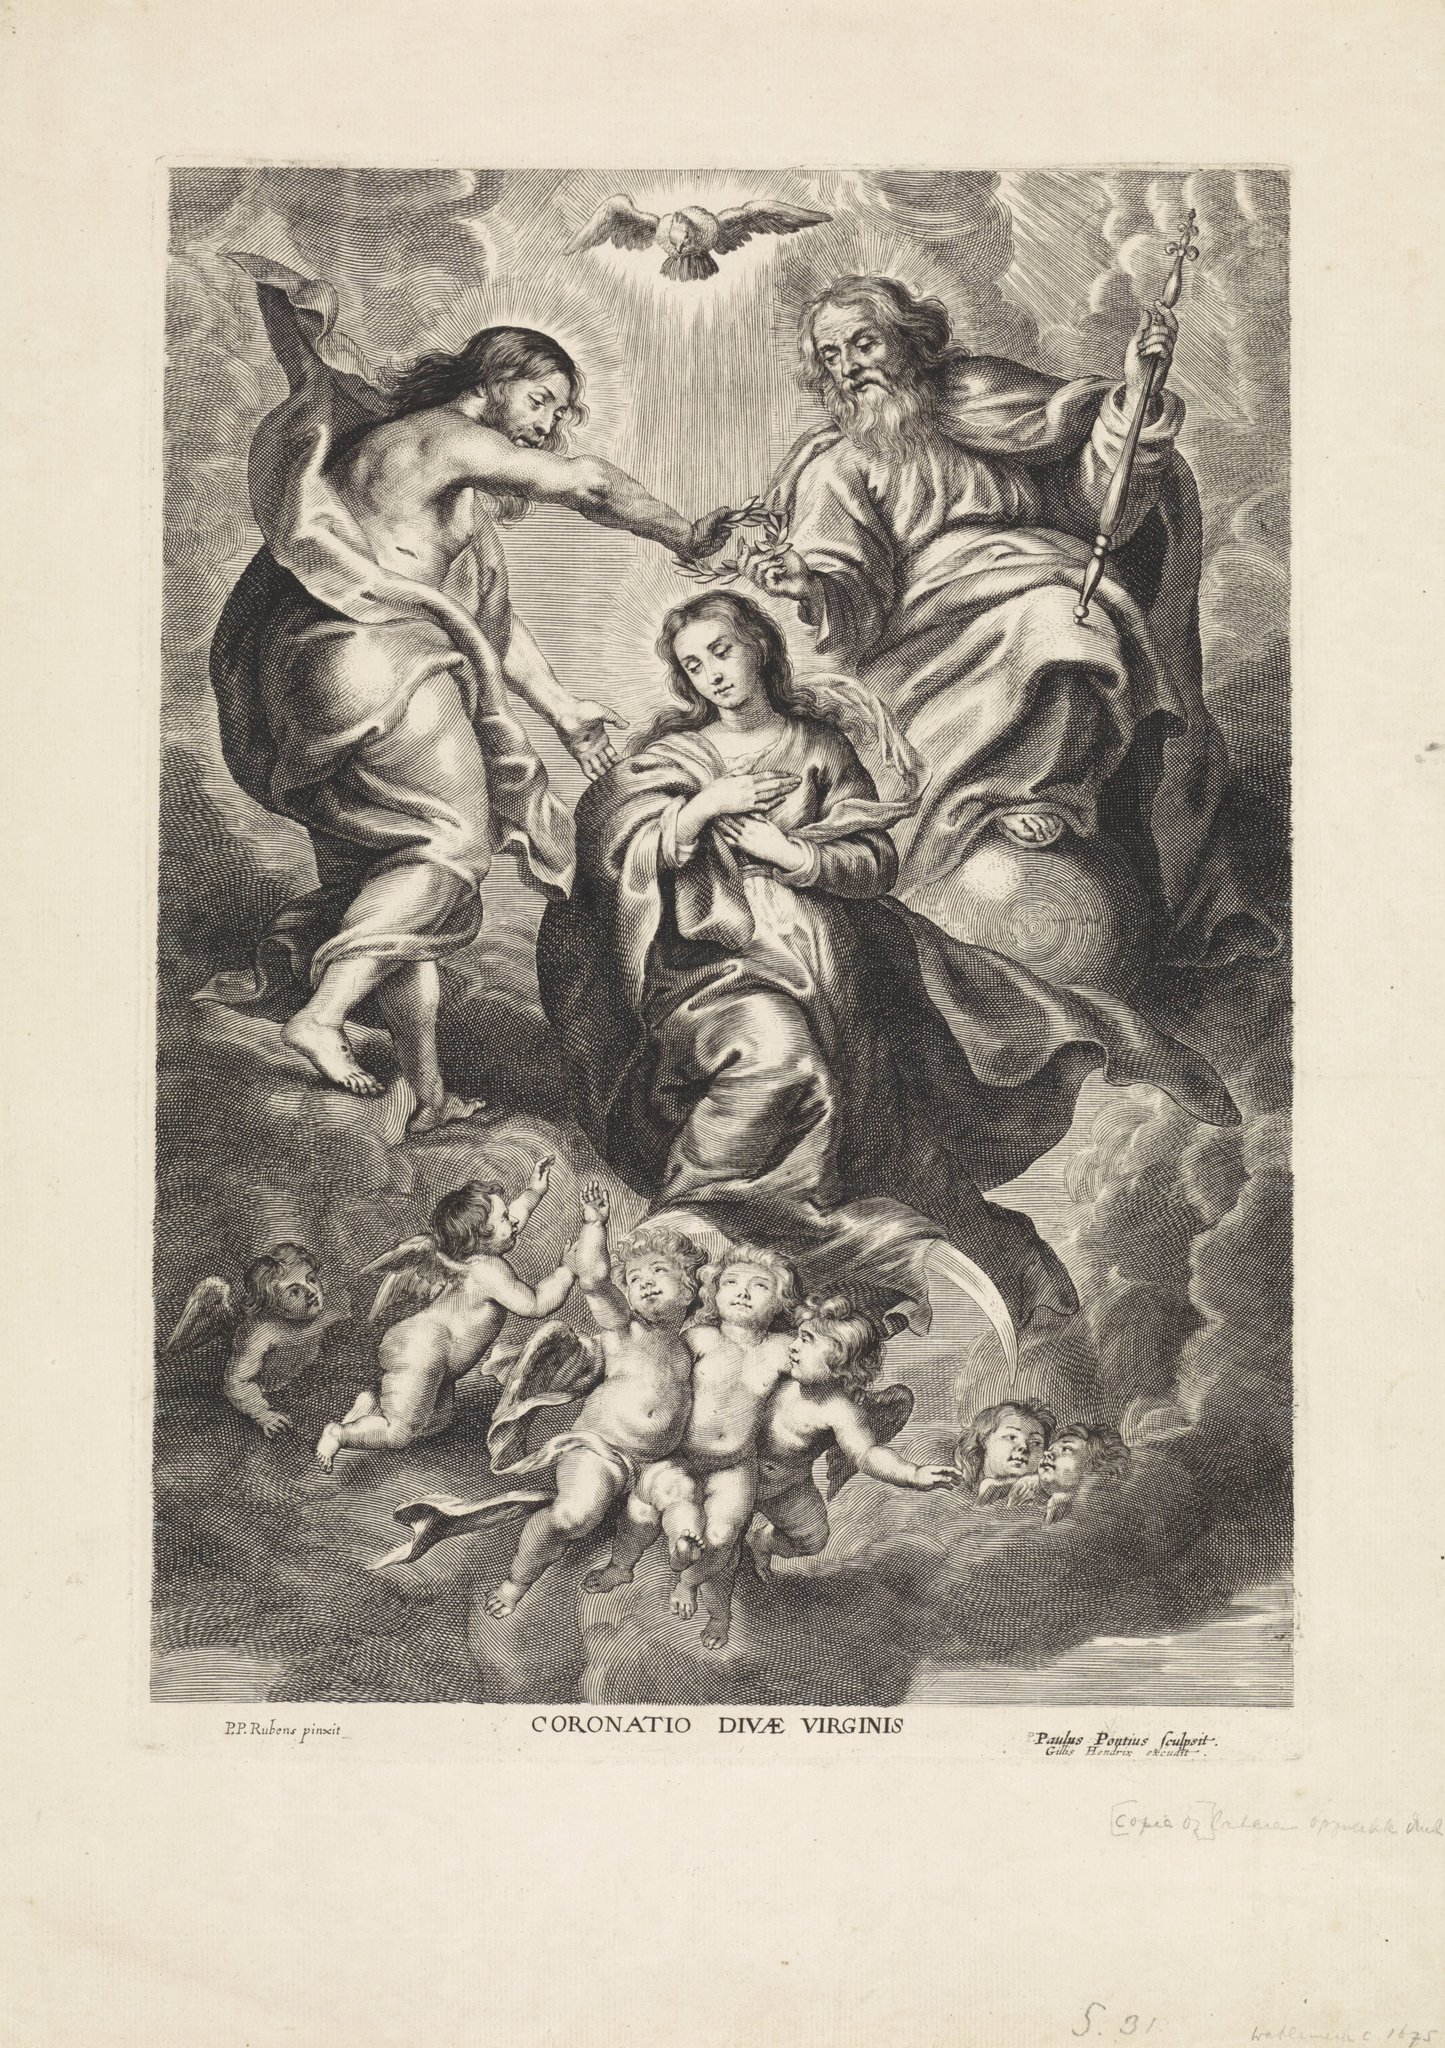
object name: print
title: Coronatio divæ virginis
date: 1616-1657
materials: paper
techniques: engraving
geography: antwerp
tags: coronation of mary by god the father and christ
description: Maria wordt gelauwerd door de Drieëenheid, respectievelijk Christus, de duif en God de Vader. Ze worden vergezeld door engelen.